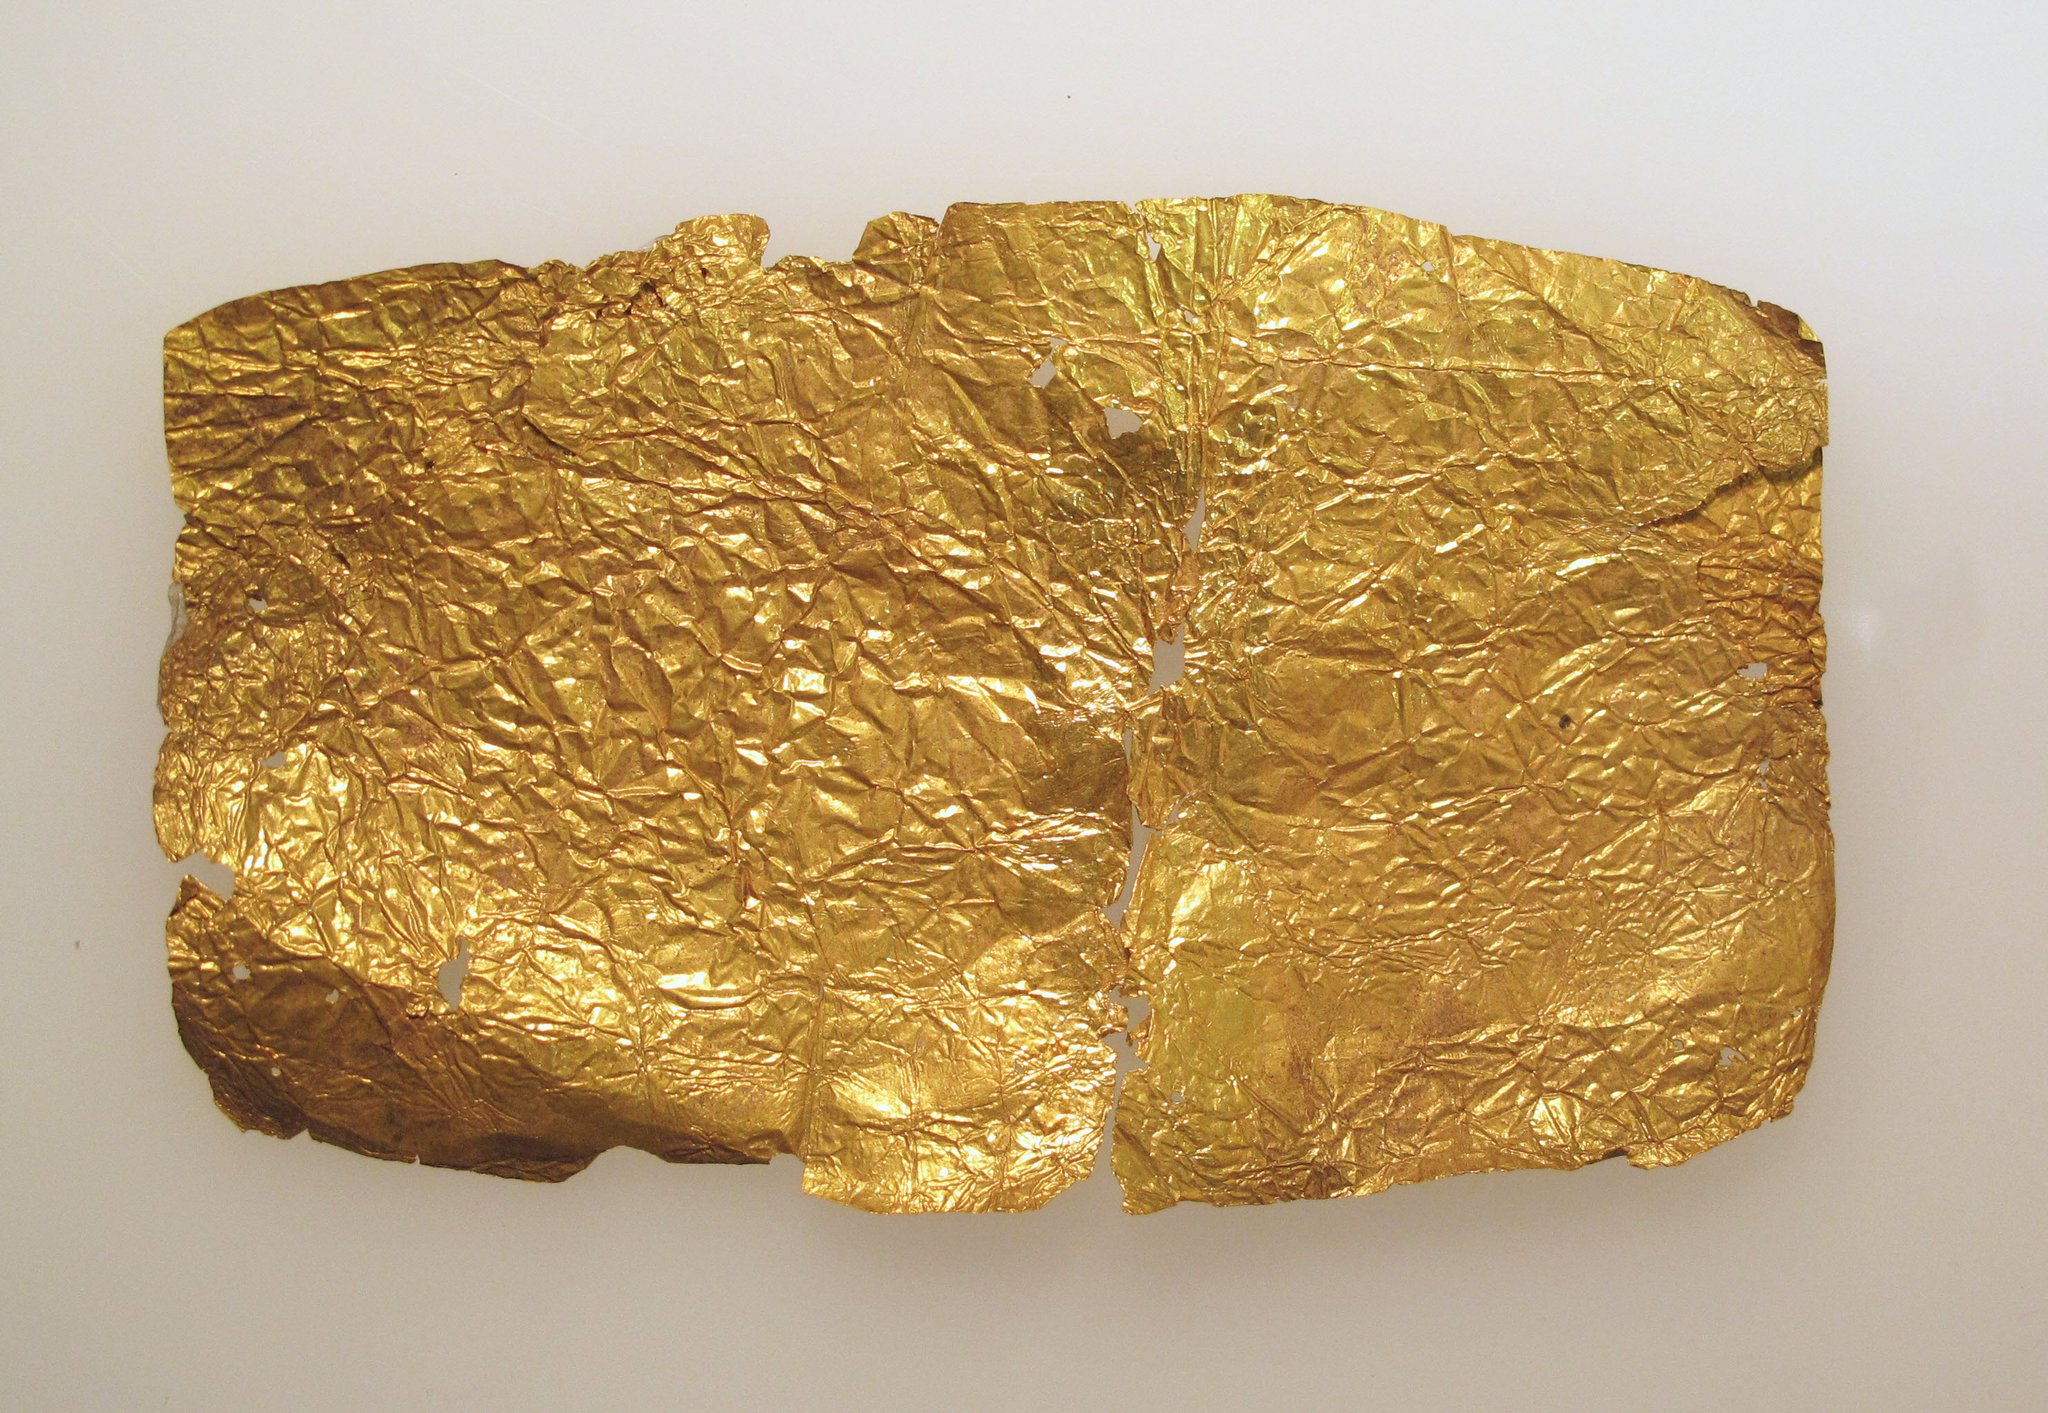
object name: frontlet of gold leaf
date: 7000 BCE-330 CE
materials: gold